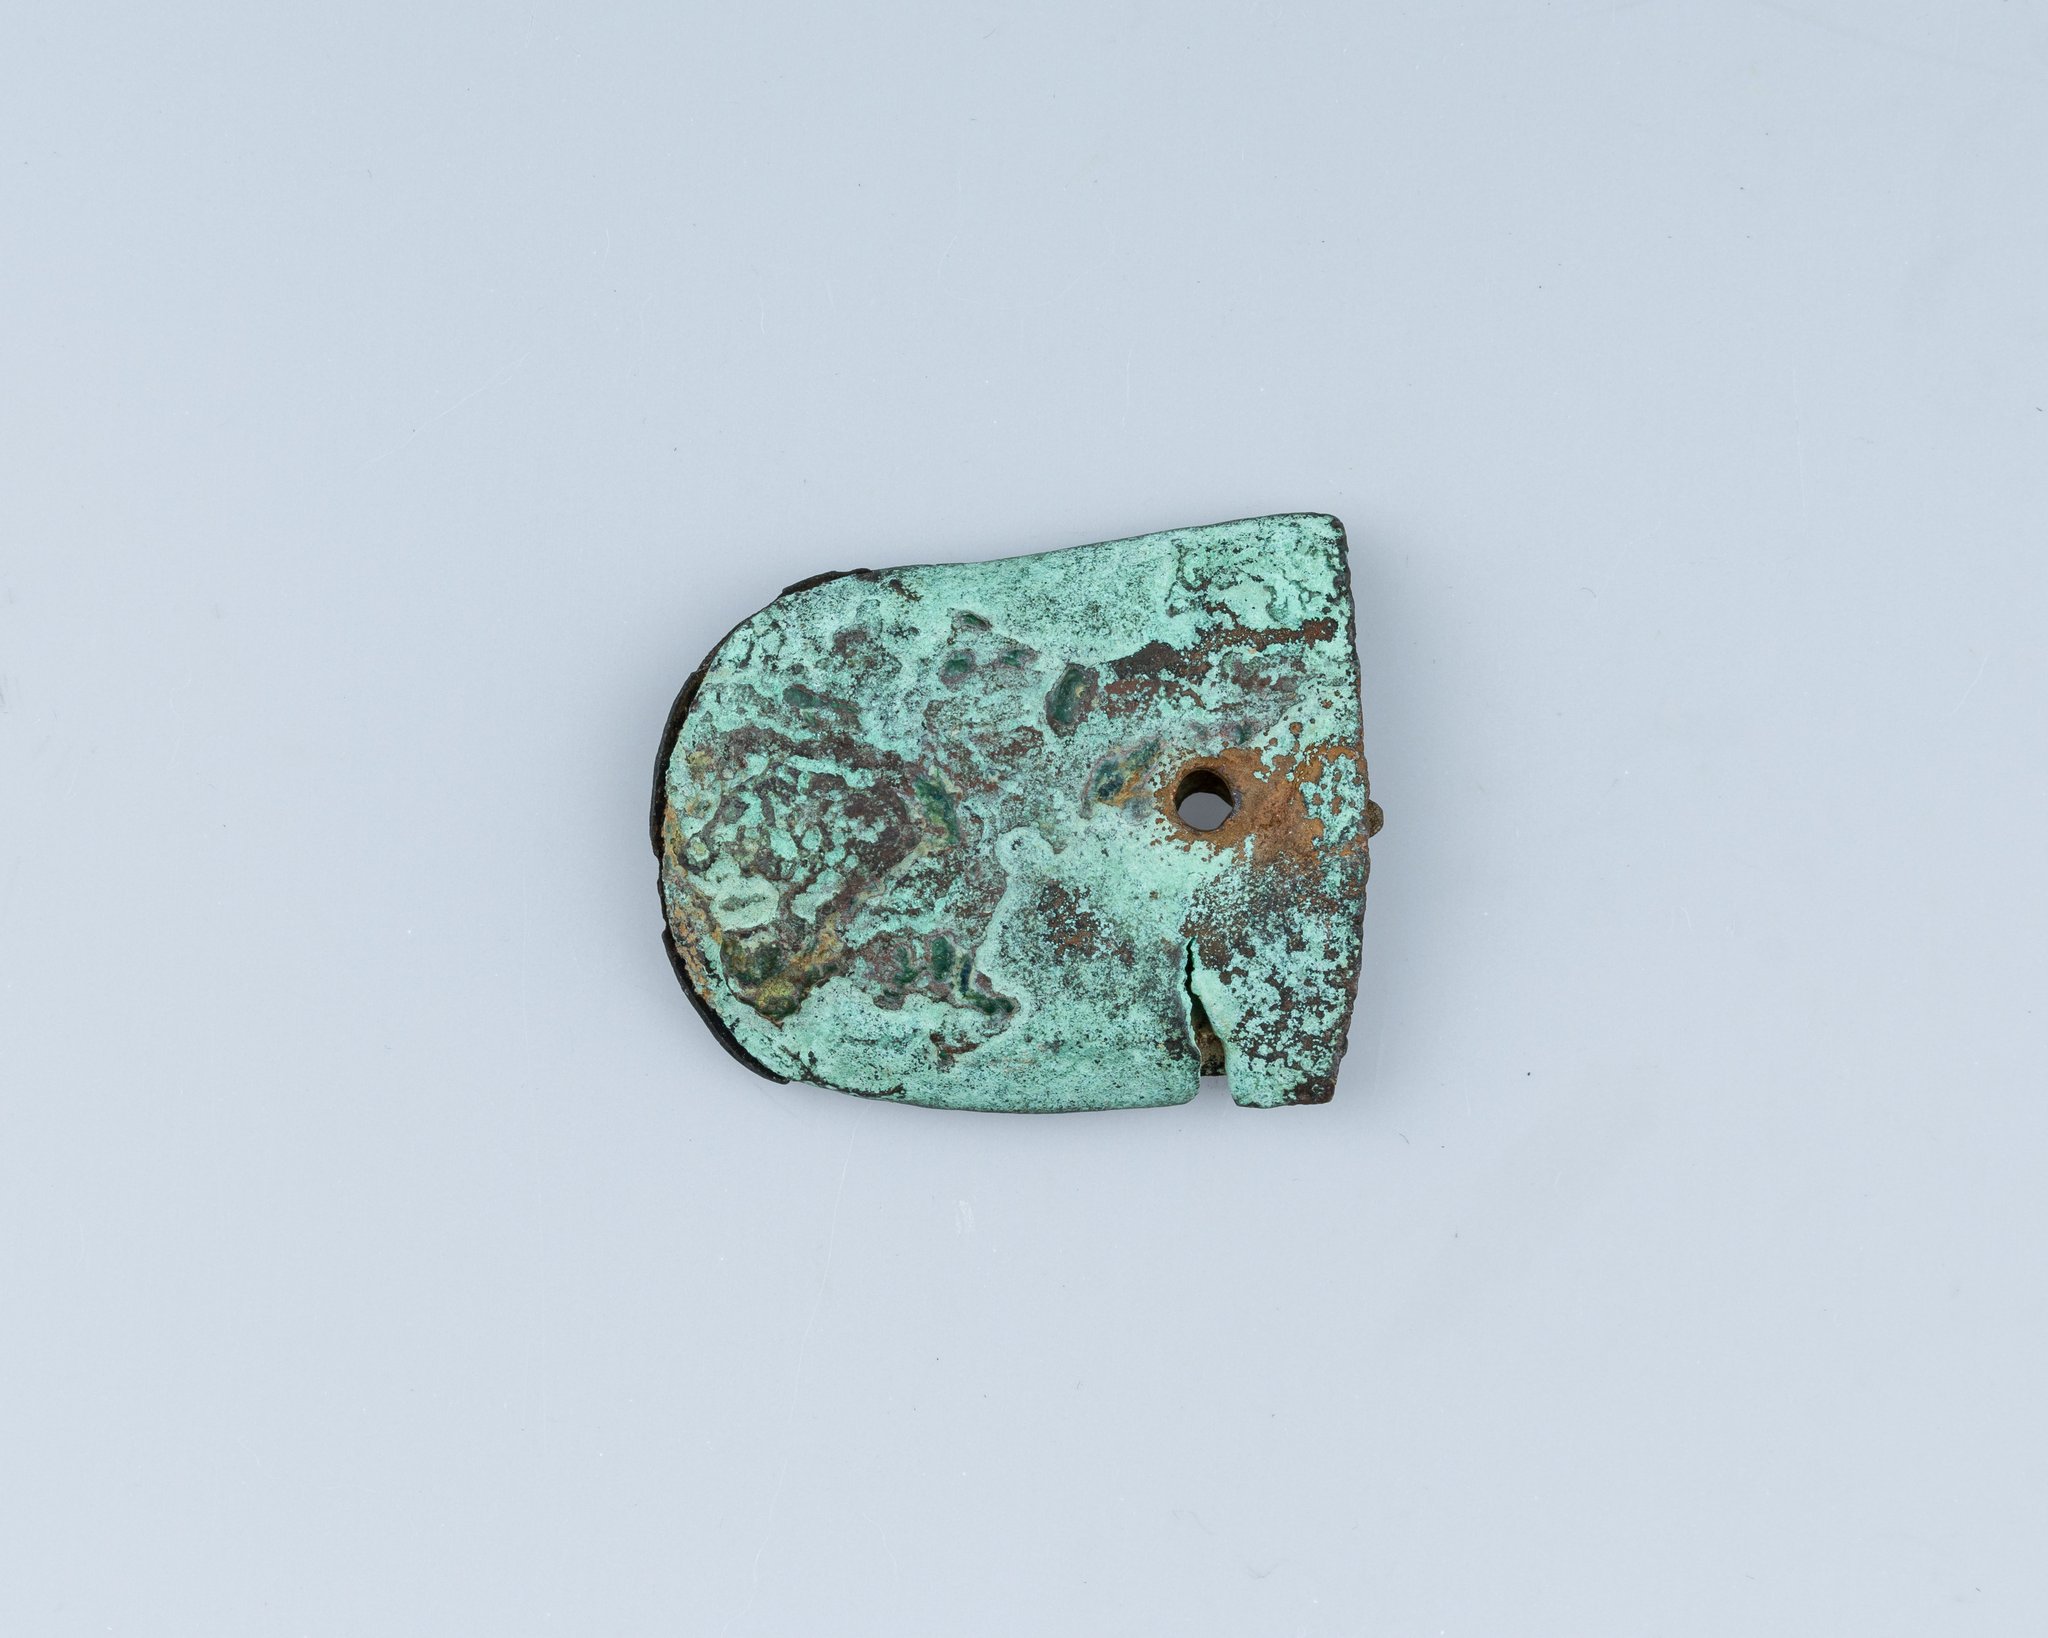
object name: mordant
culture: french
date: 1501-1533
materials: bronze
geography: france